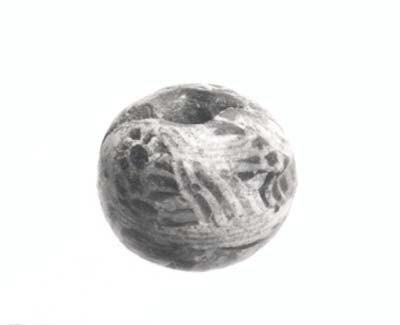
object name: bead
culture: sasanian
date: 201-700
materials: glass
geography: iran